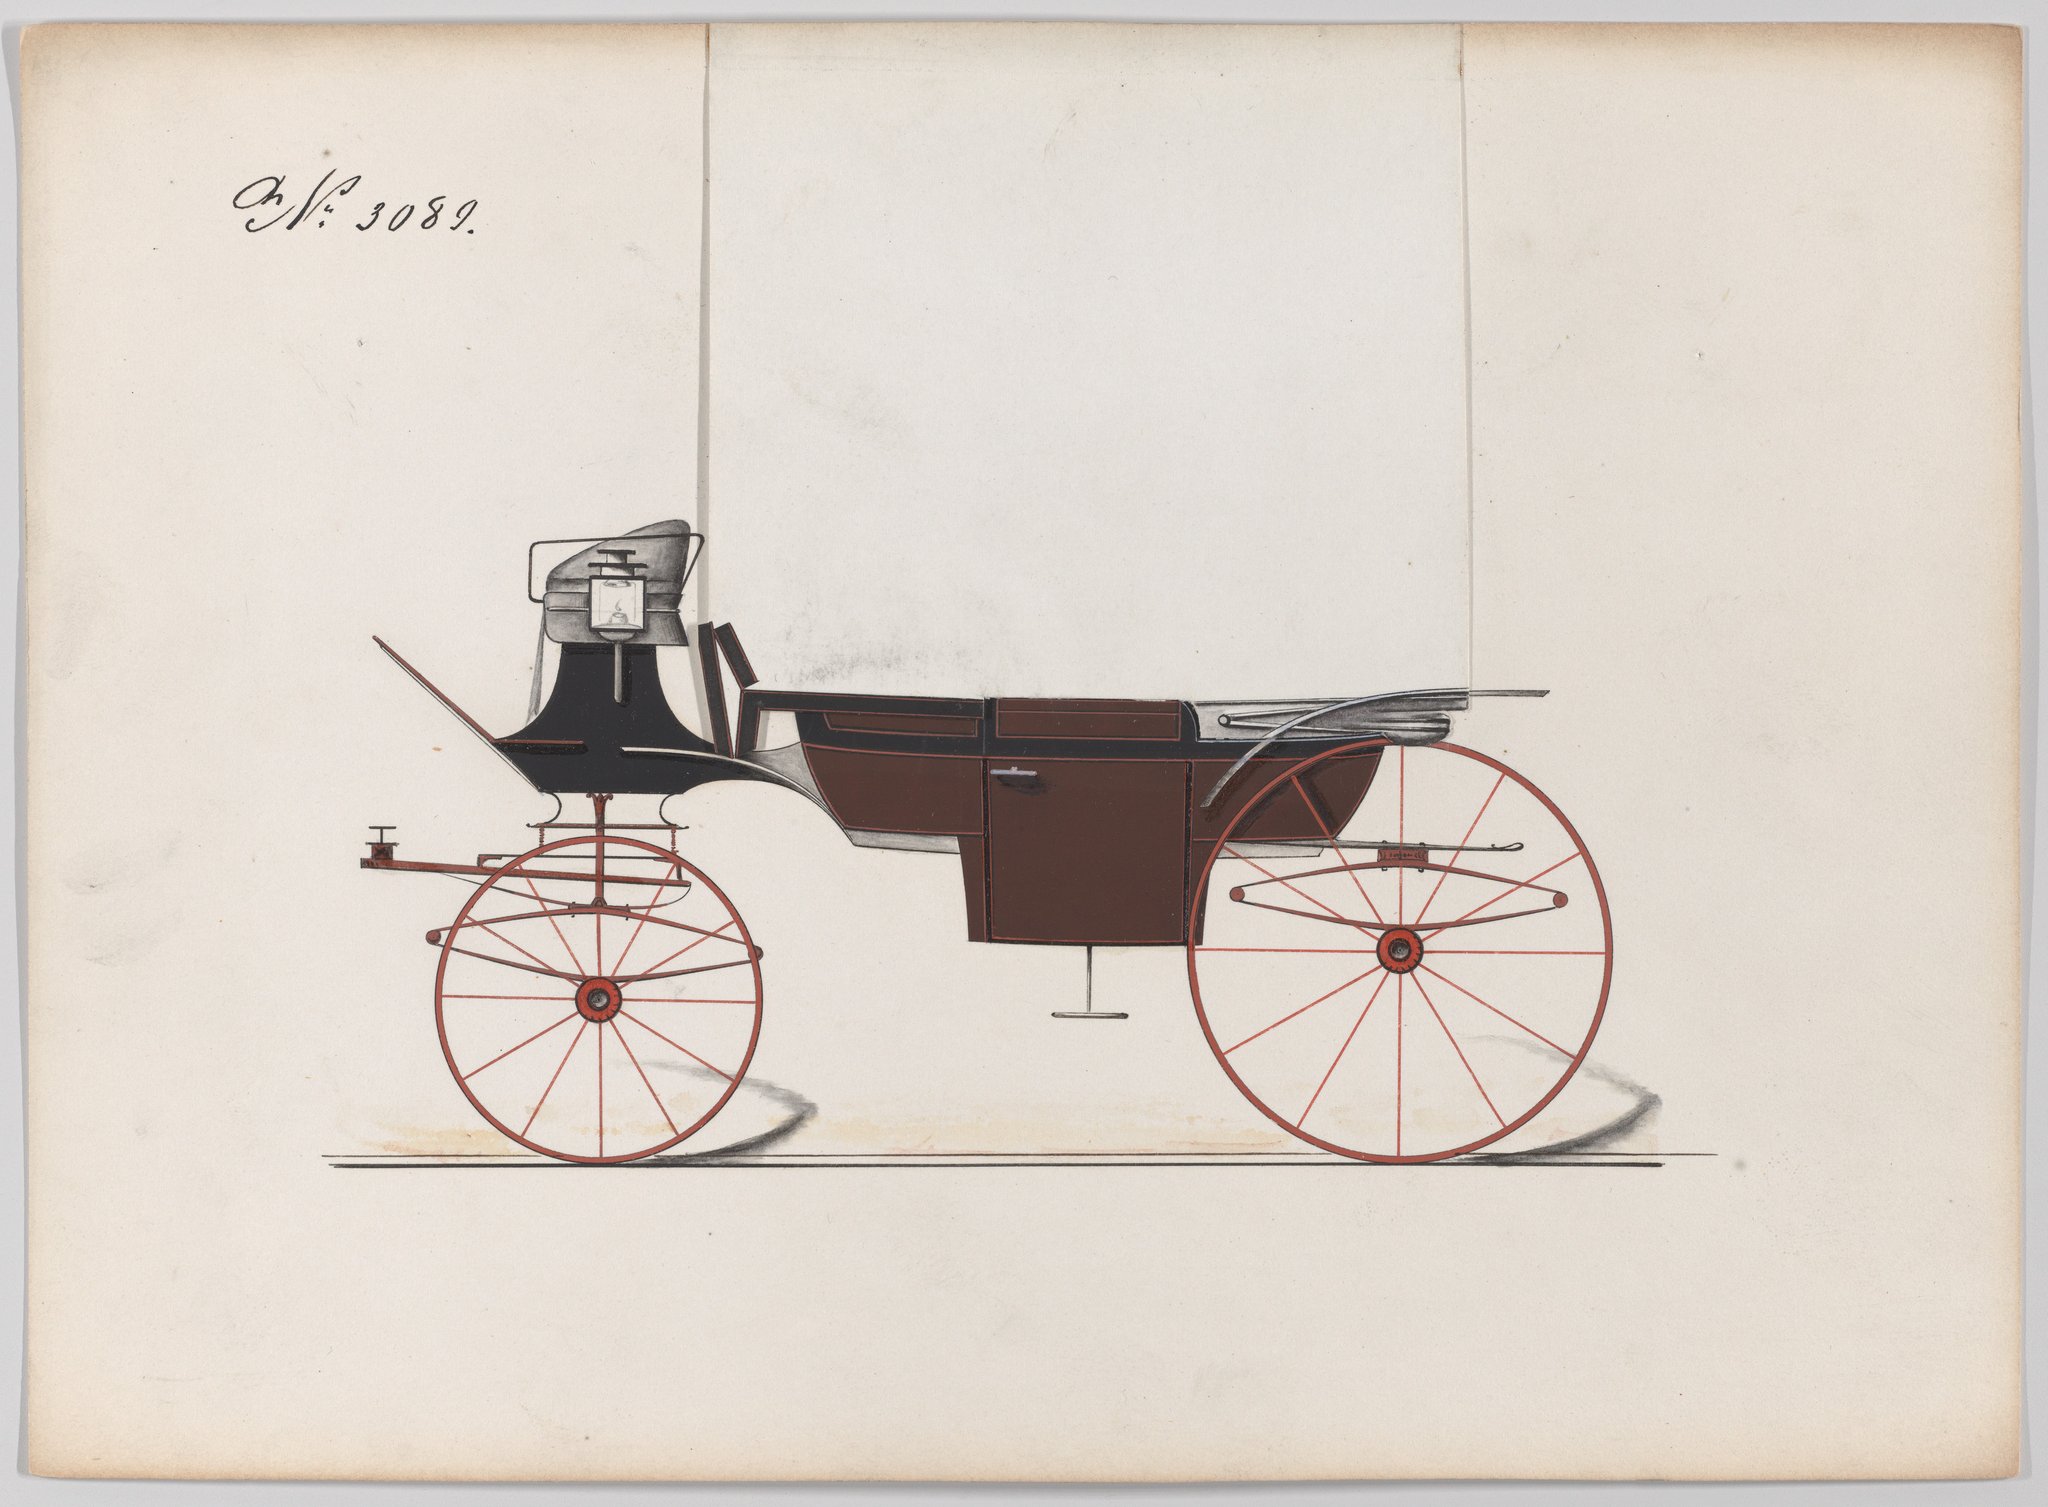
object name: drawing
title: Design for Landau, No. 3089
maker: brewster & co.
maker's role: manufacturer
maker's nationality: american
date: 1875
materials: gouache, gum arabic, ink, watercolor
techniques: pen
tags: carriages